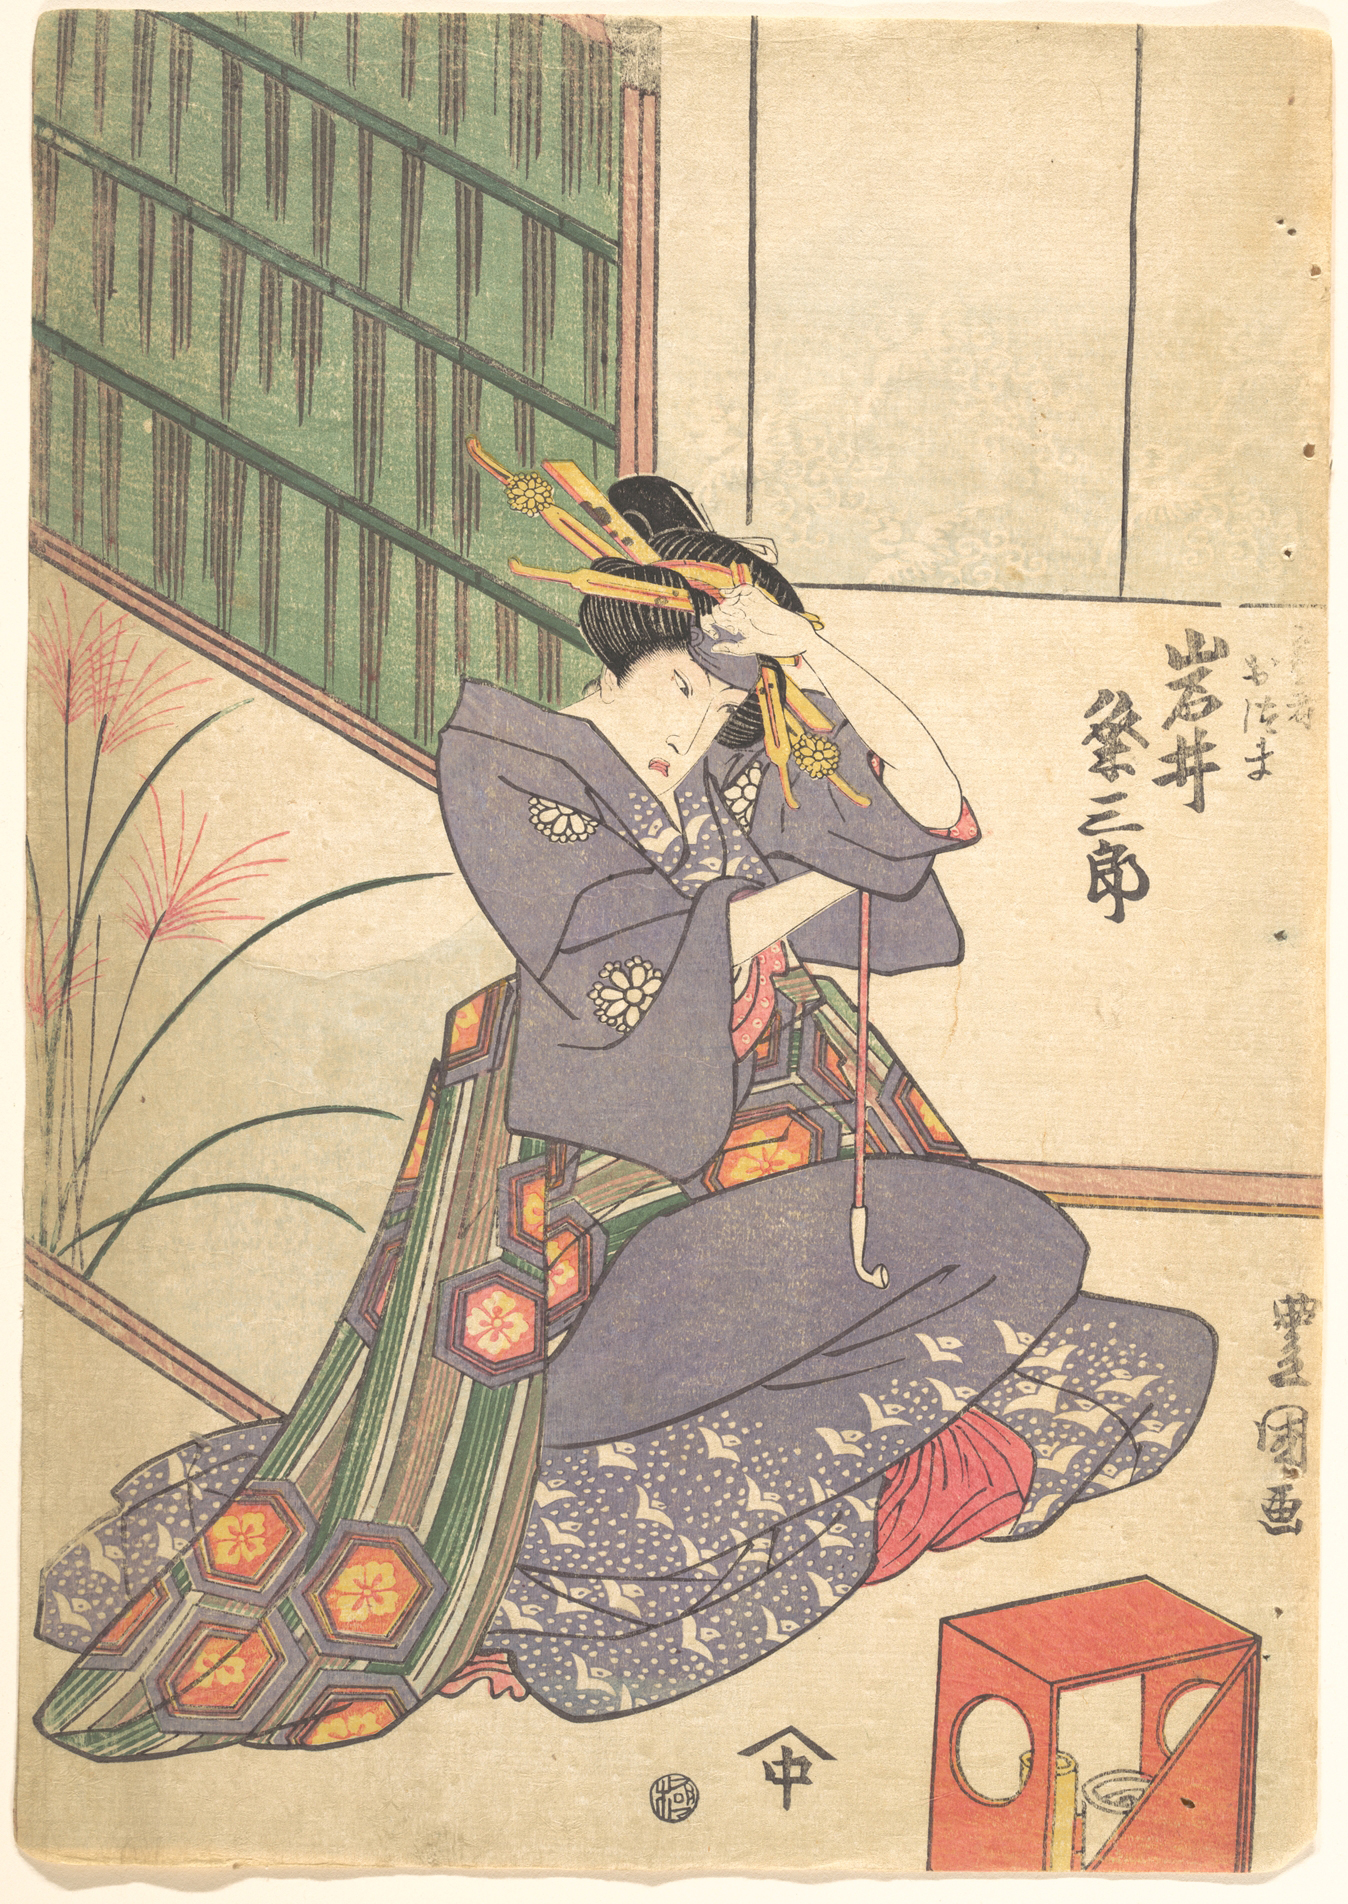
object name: print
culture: japanese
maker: utagawa kunisada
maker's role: artist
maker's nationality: japanese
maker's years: 1786-1864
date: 1801-1900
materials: ink, paper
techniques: woodblock print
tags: women